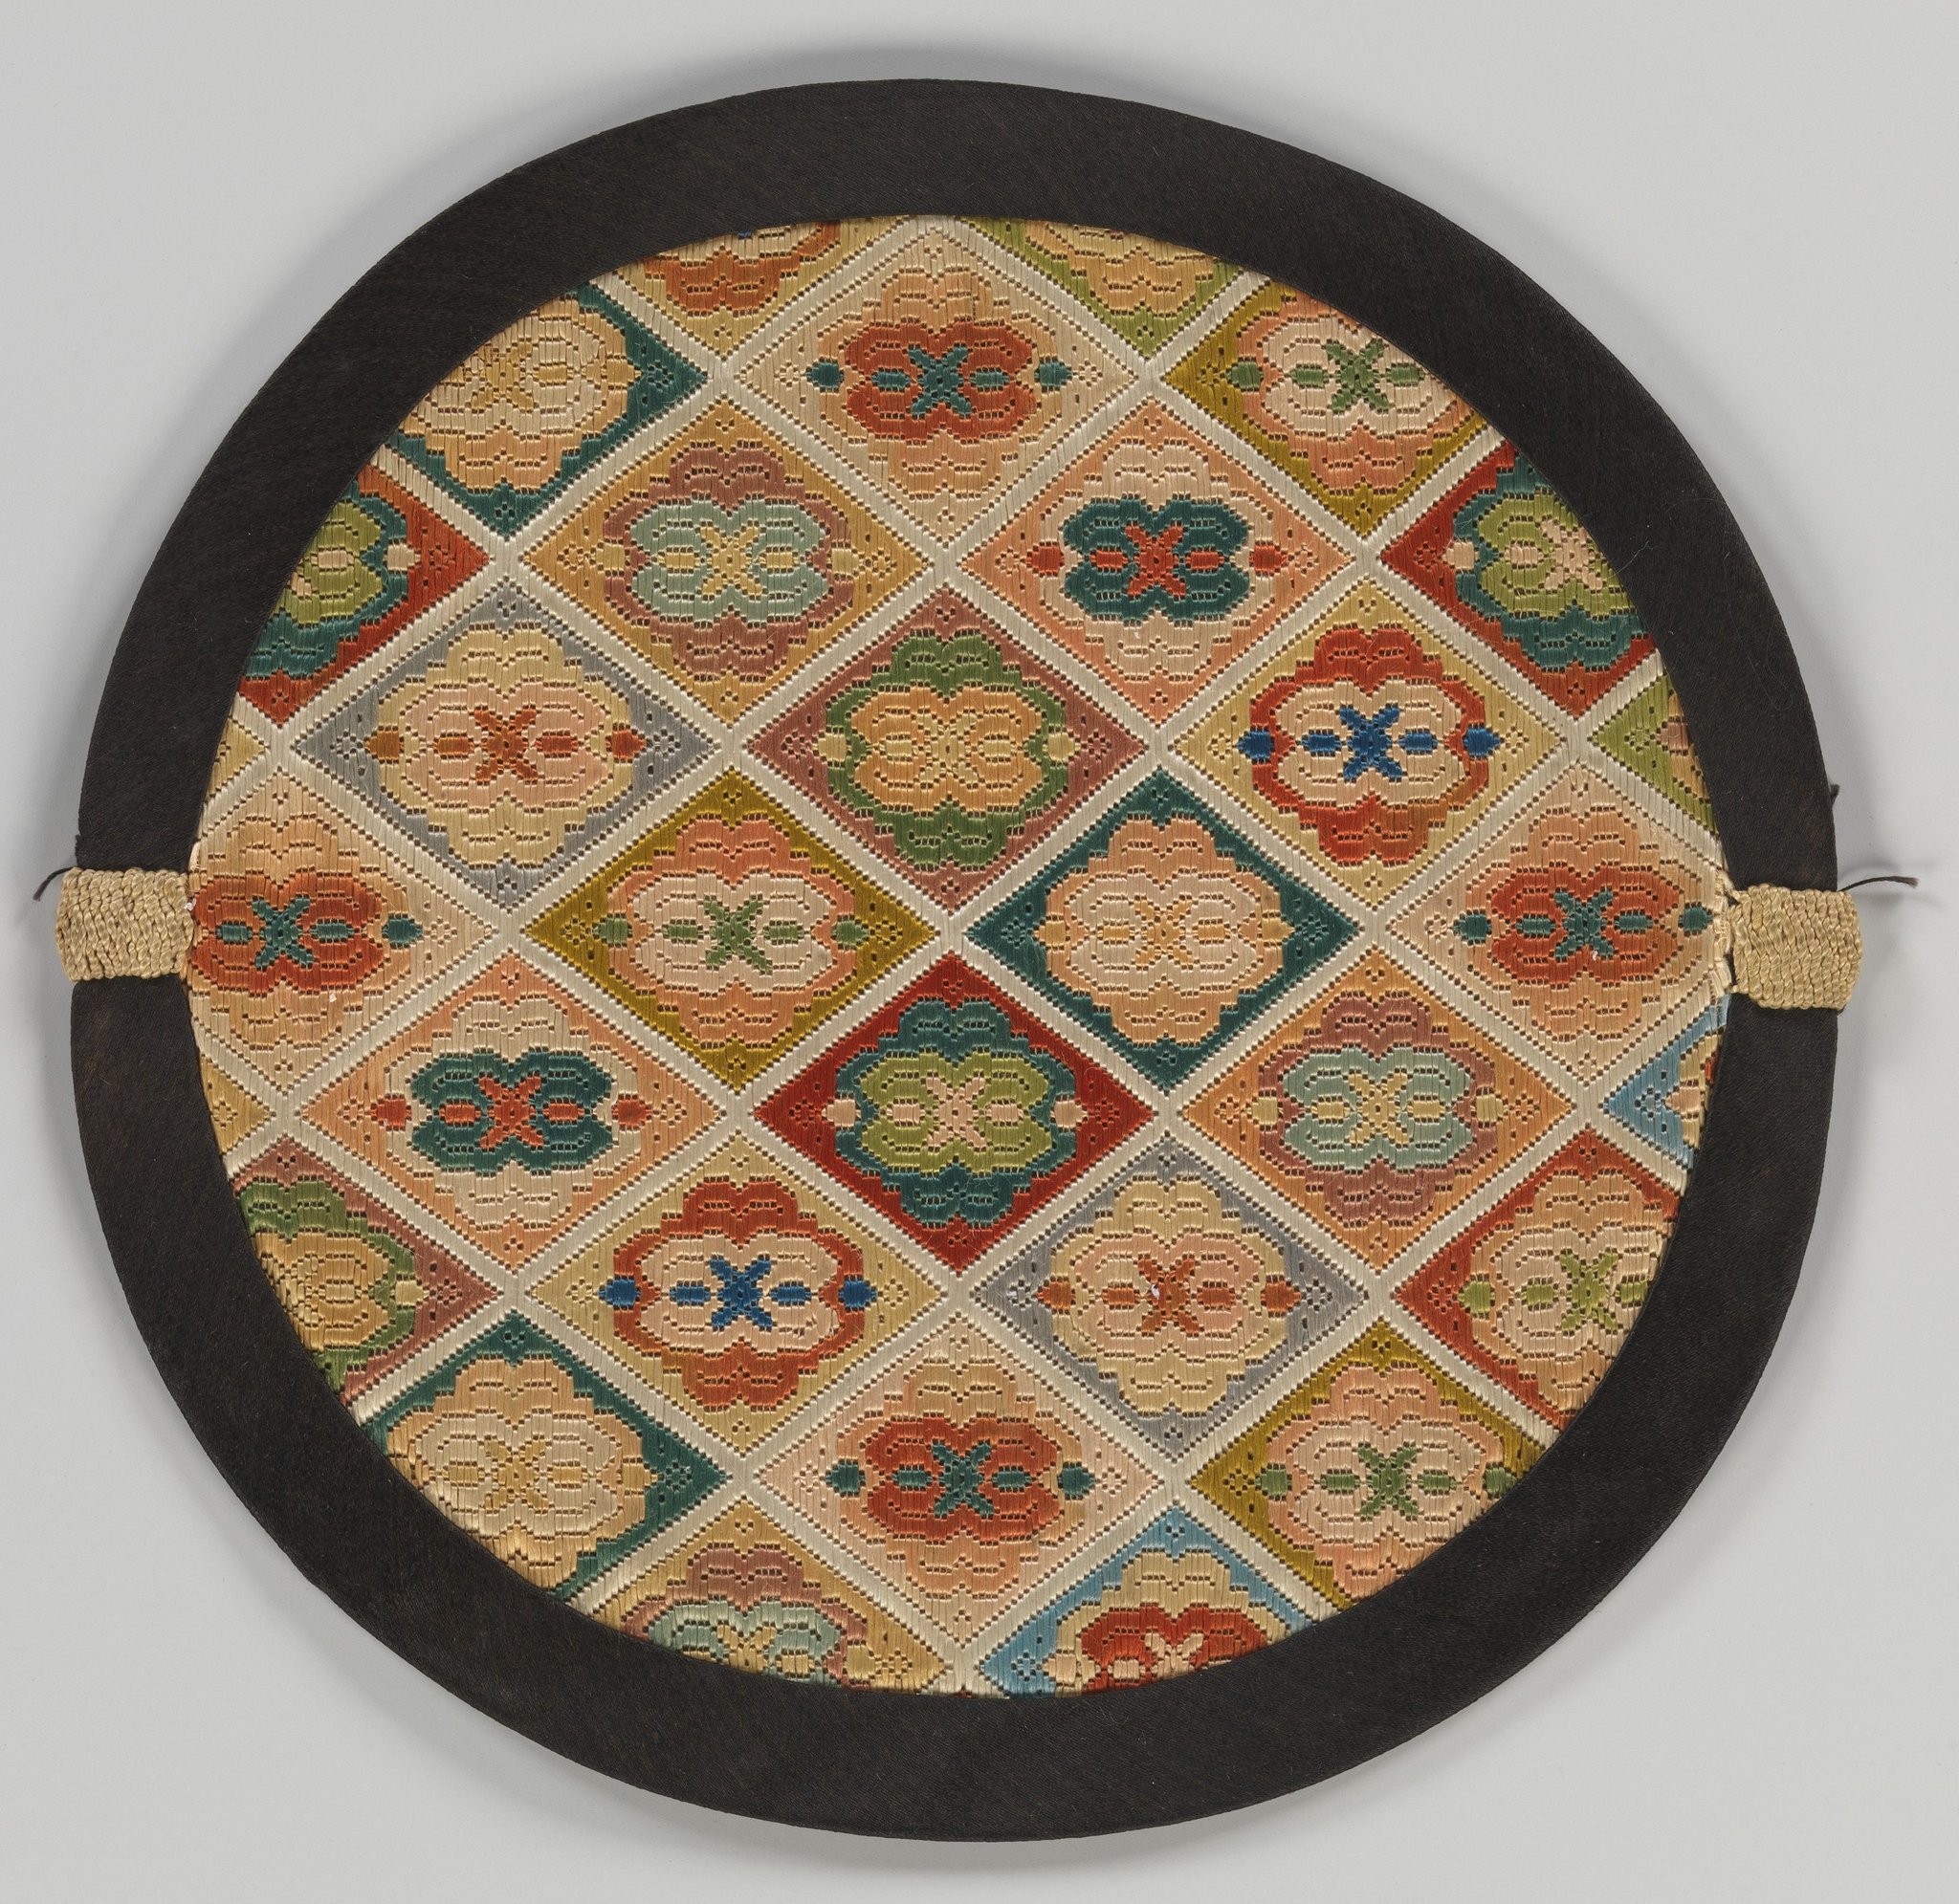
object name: mirror case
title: Mirror Case with Filled Diagonal Lattice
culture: chinese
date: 1644-1911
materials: textile, silk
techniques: embroidery